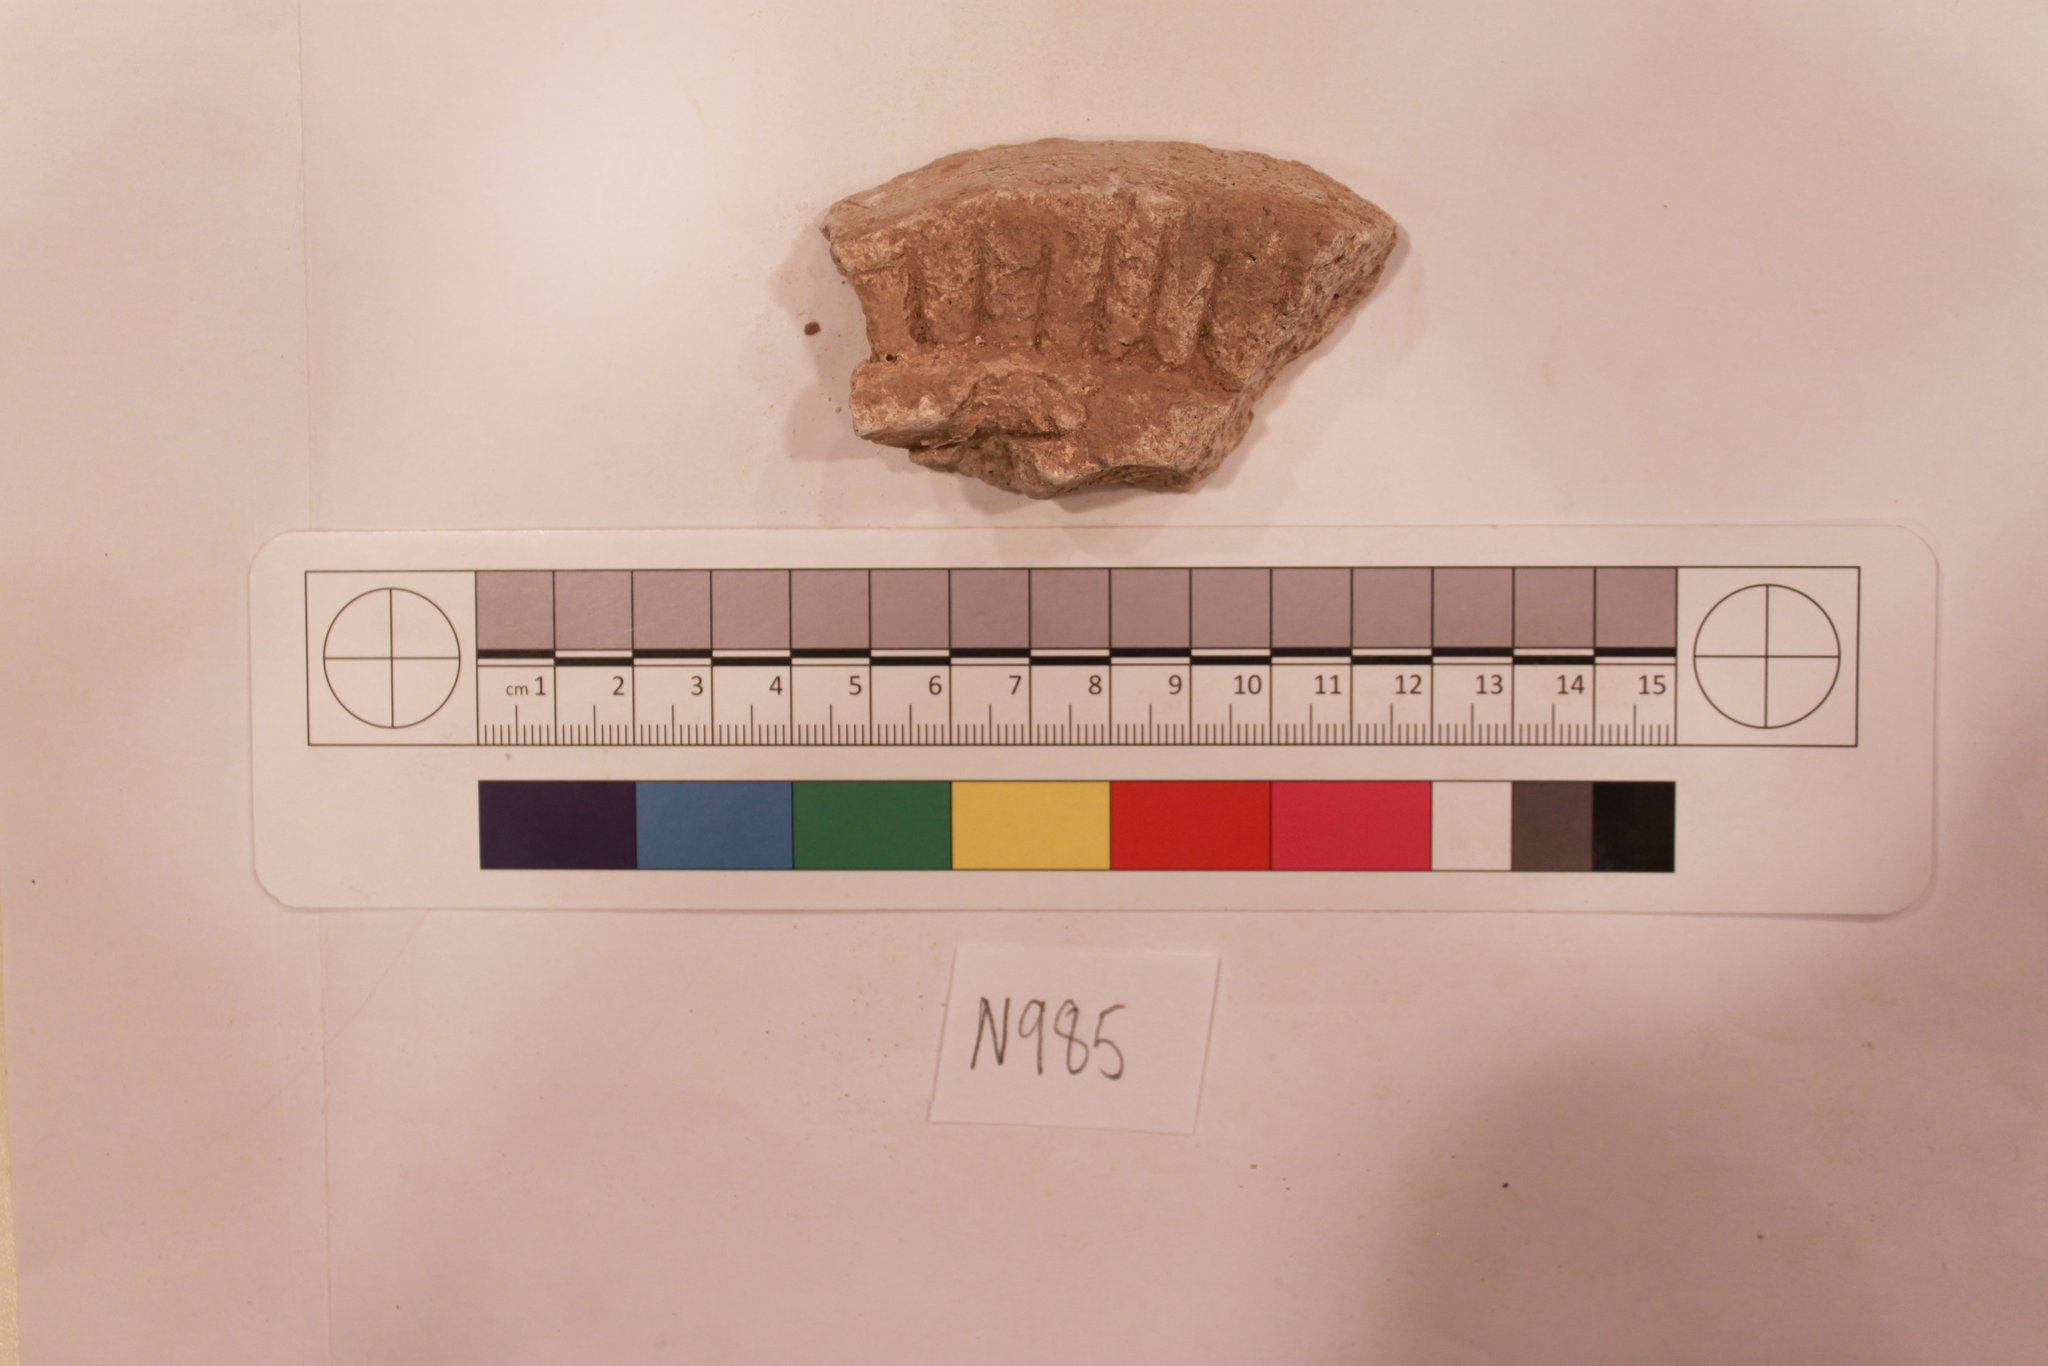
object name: fragment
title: Stucco Fragment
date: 701-1200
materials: plaster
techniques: carving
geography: iran